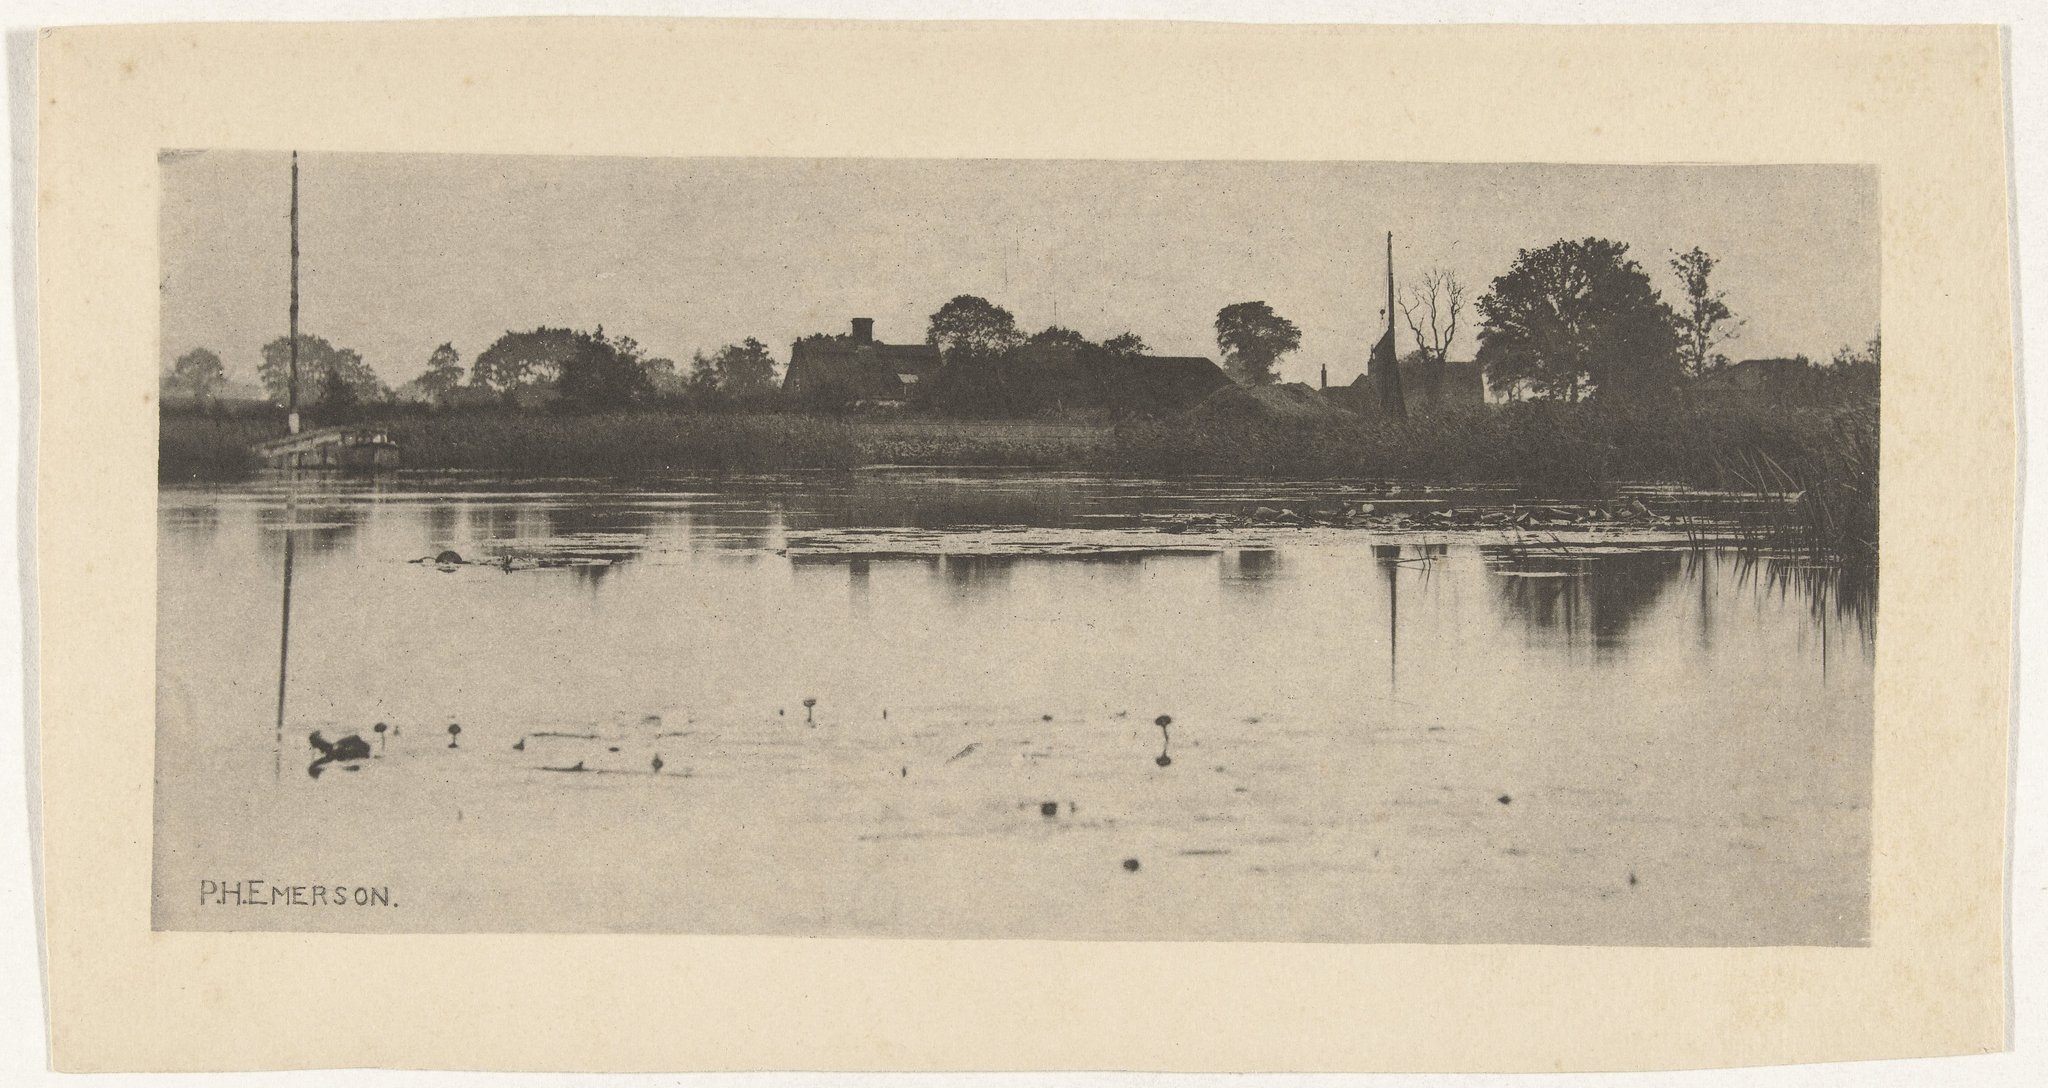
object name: photomechanical print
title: The Fringe of the Mere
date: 1883-1888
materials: cardboard, paper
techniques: photoaquatint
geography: great britain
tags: village, lake, great britain